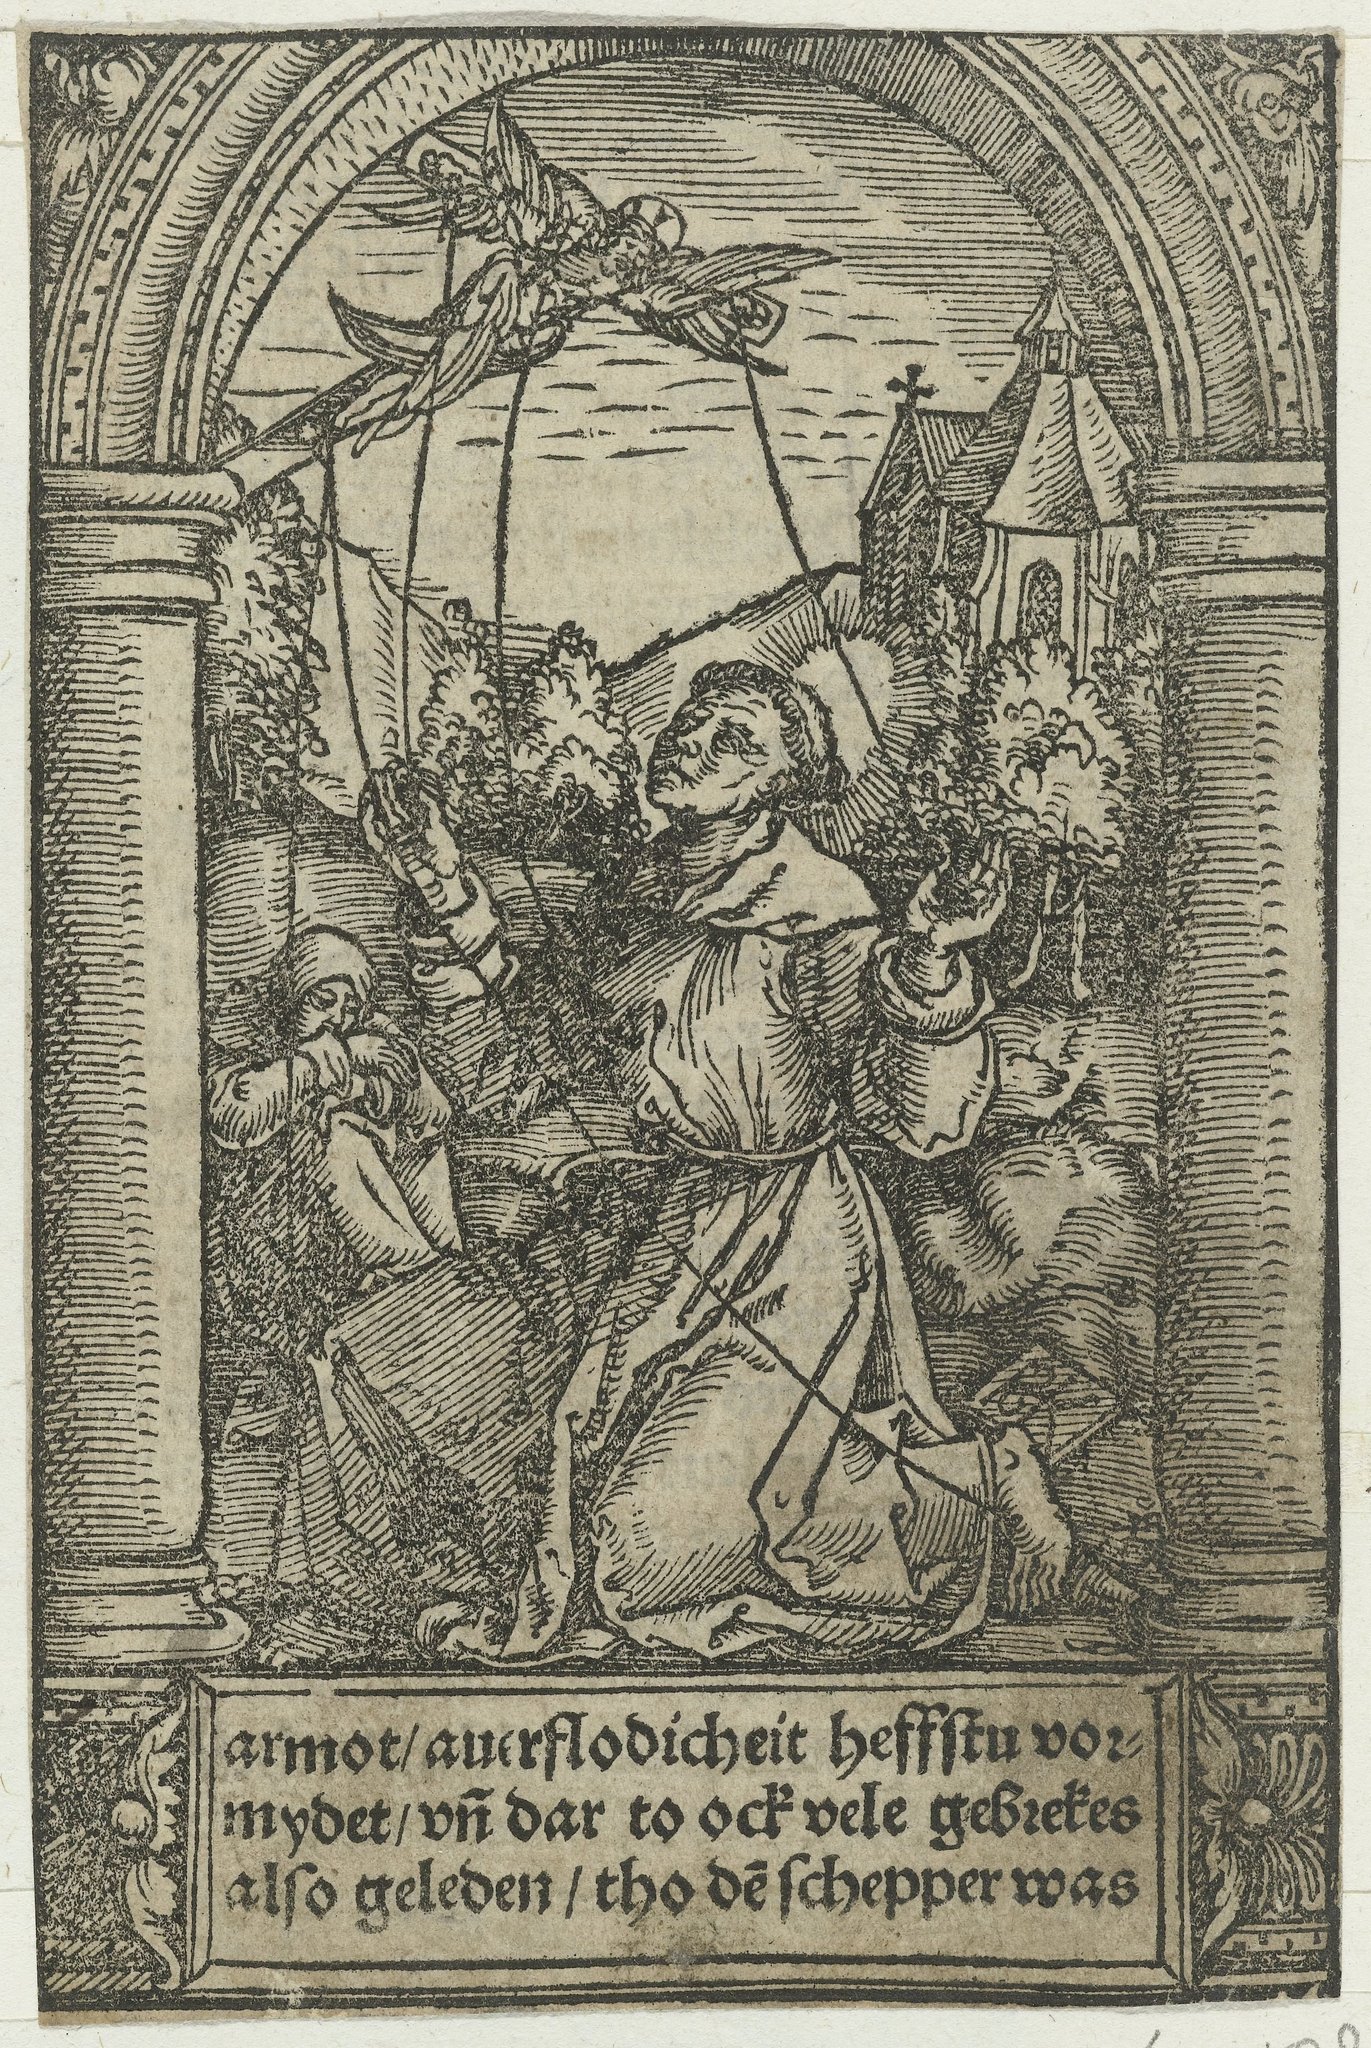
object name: album leaf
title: Stigmatisatie van de H. Franciscus van Assisi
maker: hans springinklee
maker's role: print maker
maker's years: -1540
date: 1518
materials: paper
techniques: woodcut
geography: nuremberg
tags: stigmatization of st. francis of assisi: in retreat on mount alverna, he beholds a vision of christ on the cross enveloped by wings (like a seraph with six wings); rays passing down to the body of the kneeling saint form the marks of the five wounds of christ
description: Franciscus, in gebed op de berg Monte Alverna, heeft een visioen van Christus als een serafijn op het kruis. Hij ontvangt de stigmata van Christus. Prent maakt deel uit van een album.